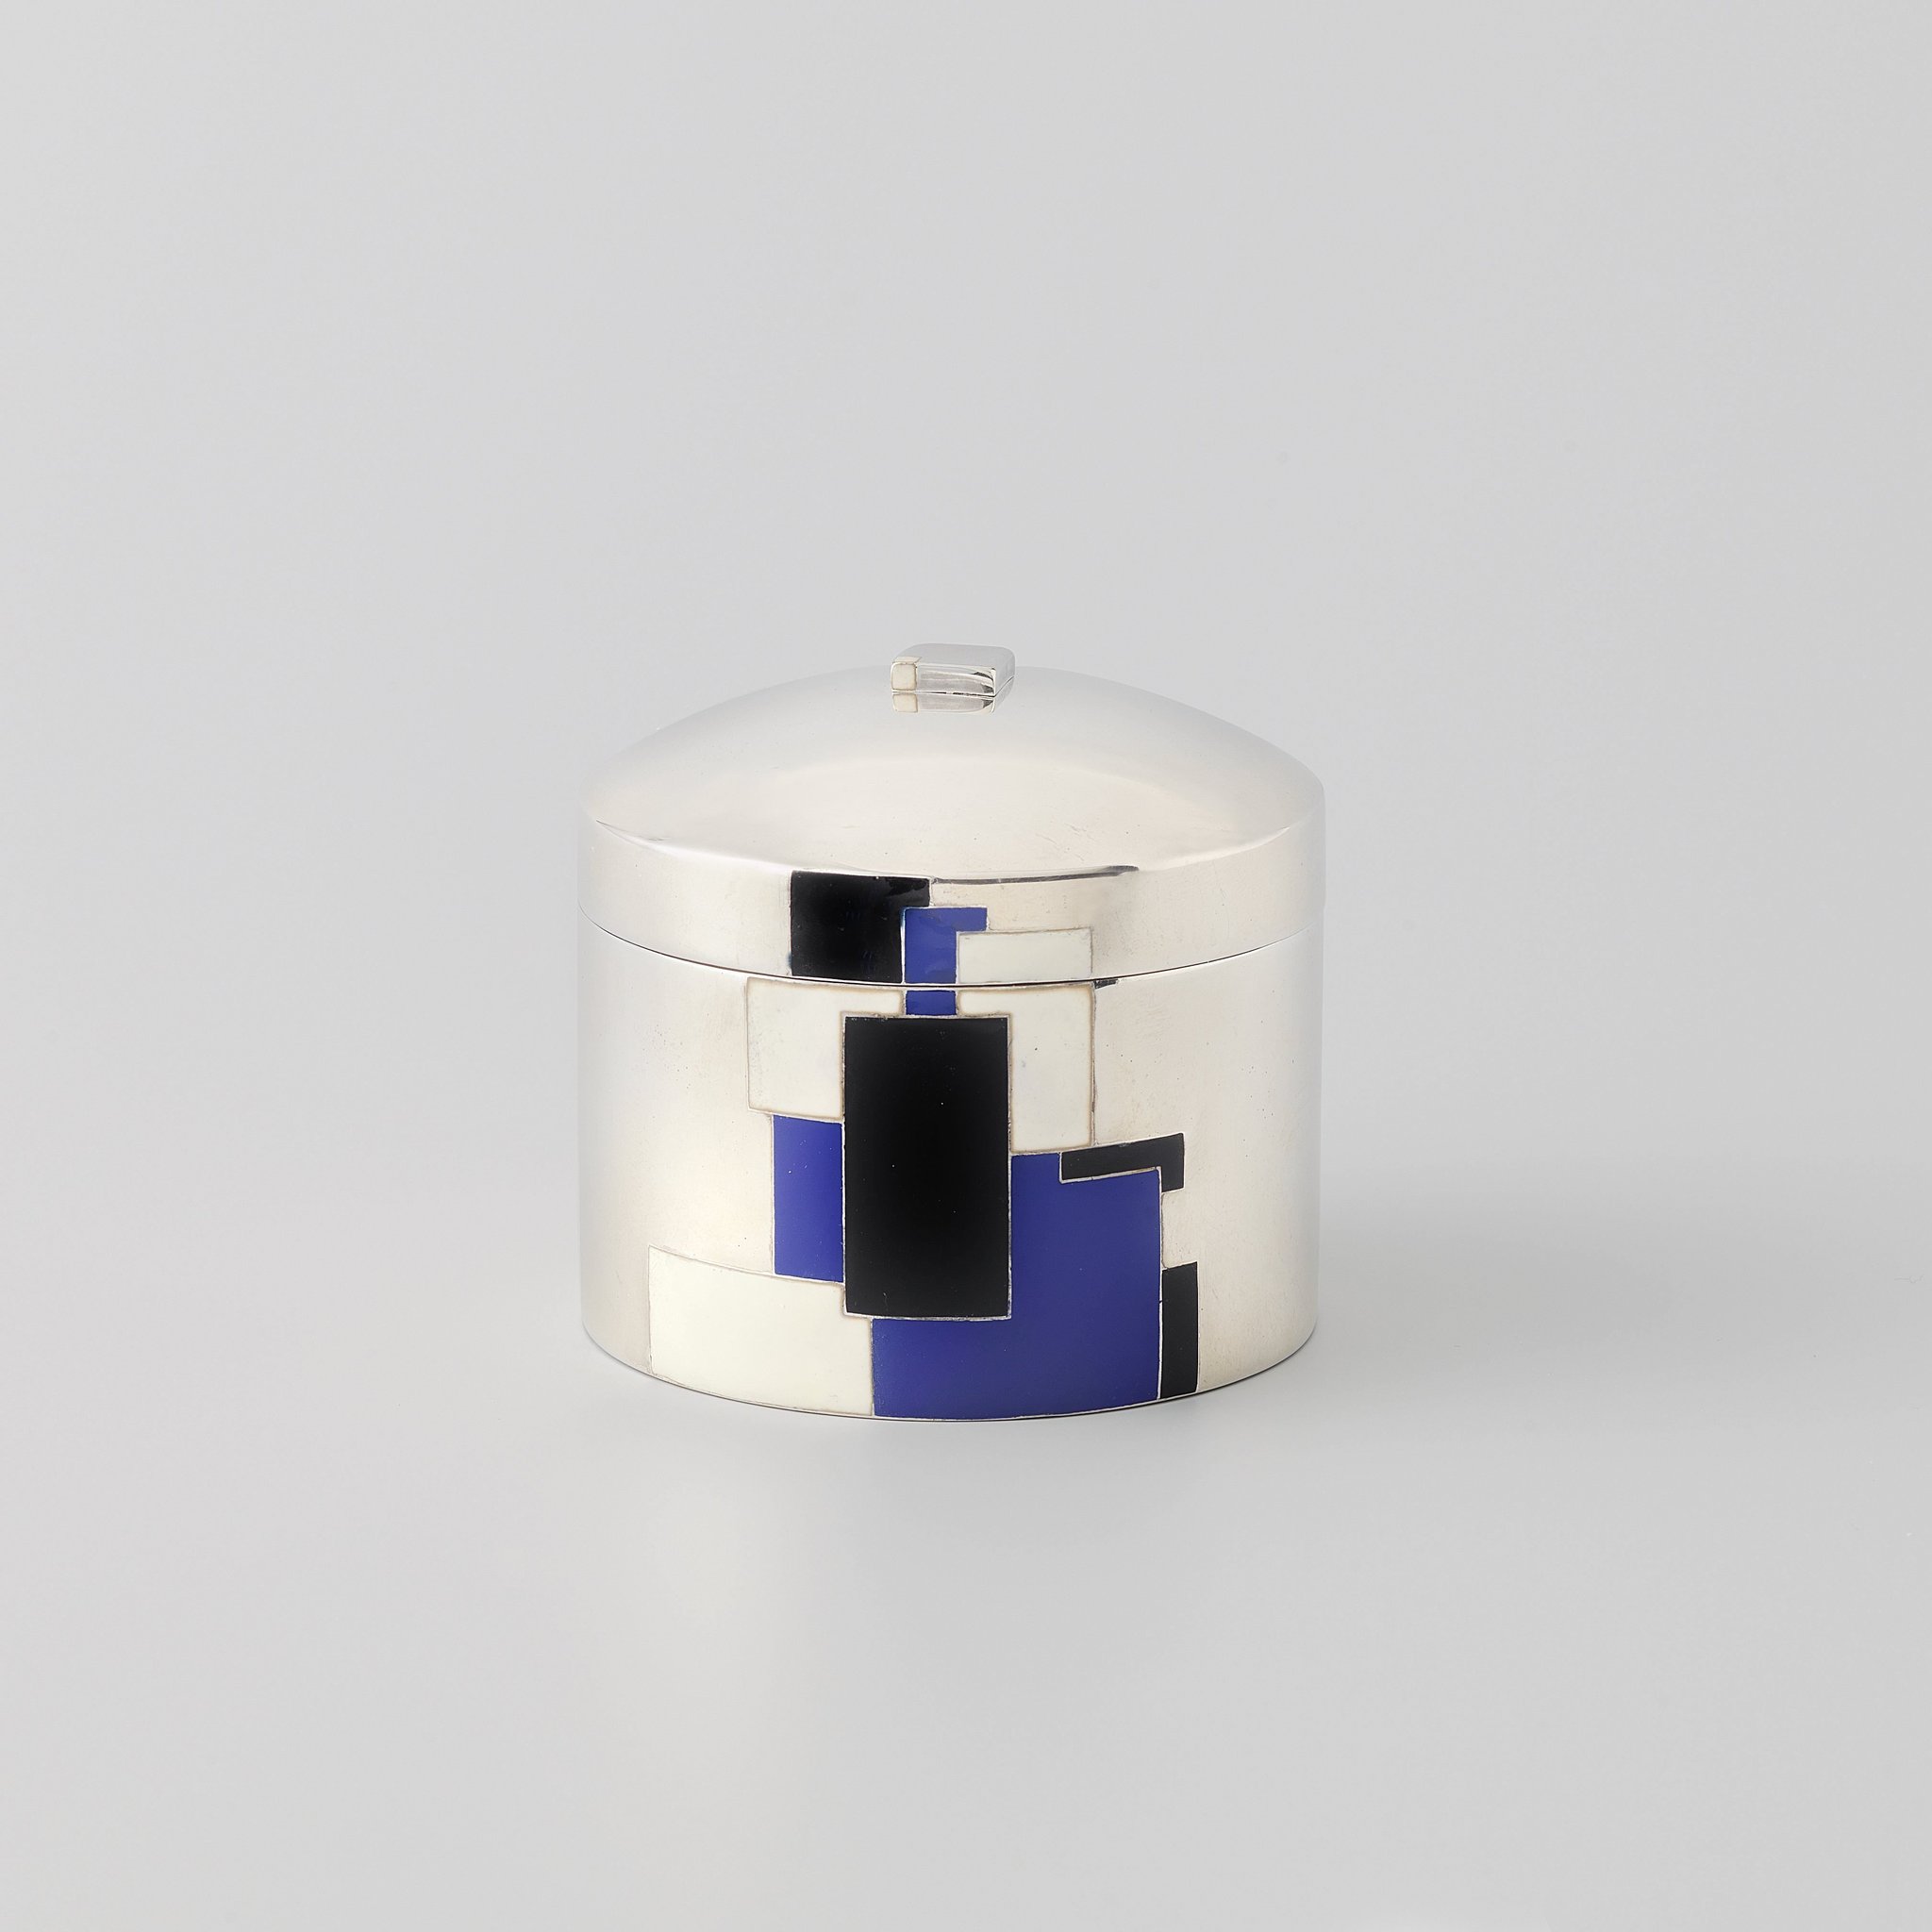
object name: box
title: Doos van zilver met abstract-geometrische versiering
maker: Anonymous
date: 1919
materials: silver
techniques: enameling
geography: utrecht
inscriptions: date letter, alloy mark, town mark, maker's mark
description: Cilindrische doos met bollend deksel uitgevoerd in zilver, voorzien van een abstract-geometrische compositie van emailcloisonne in de kleuren wit, zwart en blauw. De decoratie bevindt zich aan een zijde van de doos en loopt door op de rand van het deksel. De knop van het deksel is gedecoreerd met een kleine kubus van wit email.